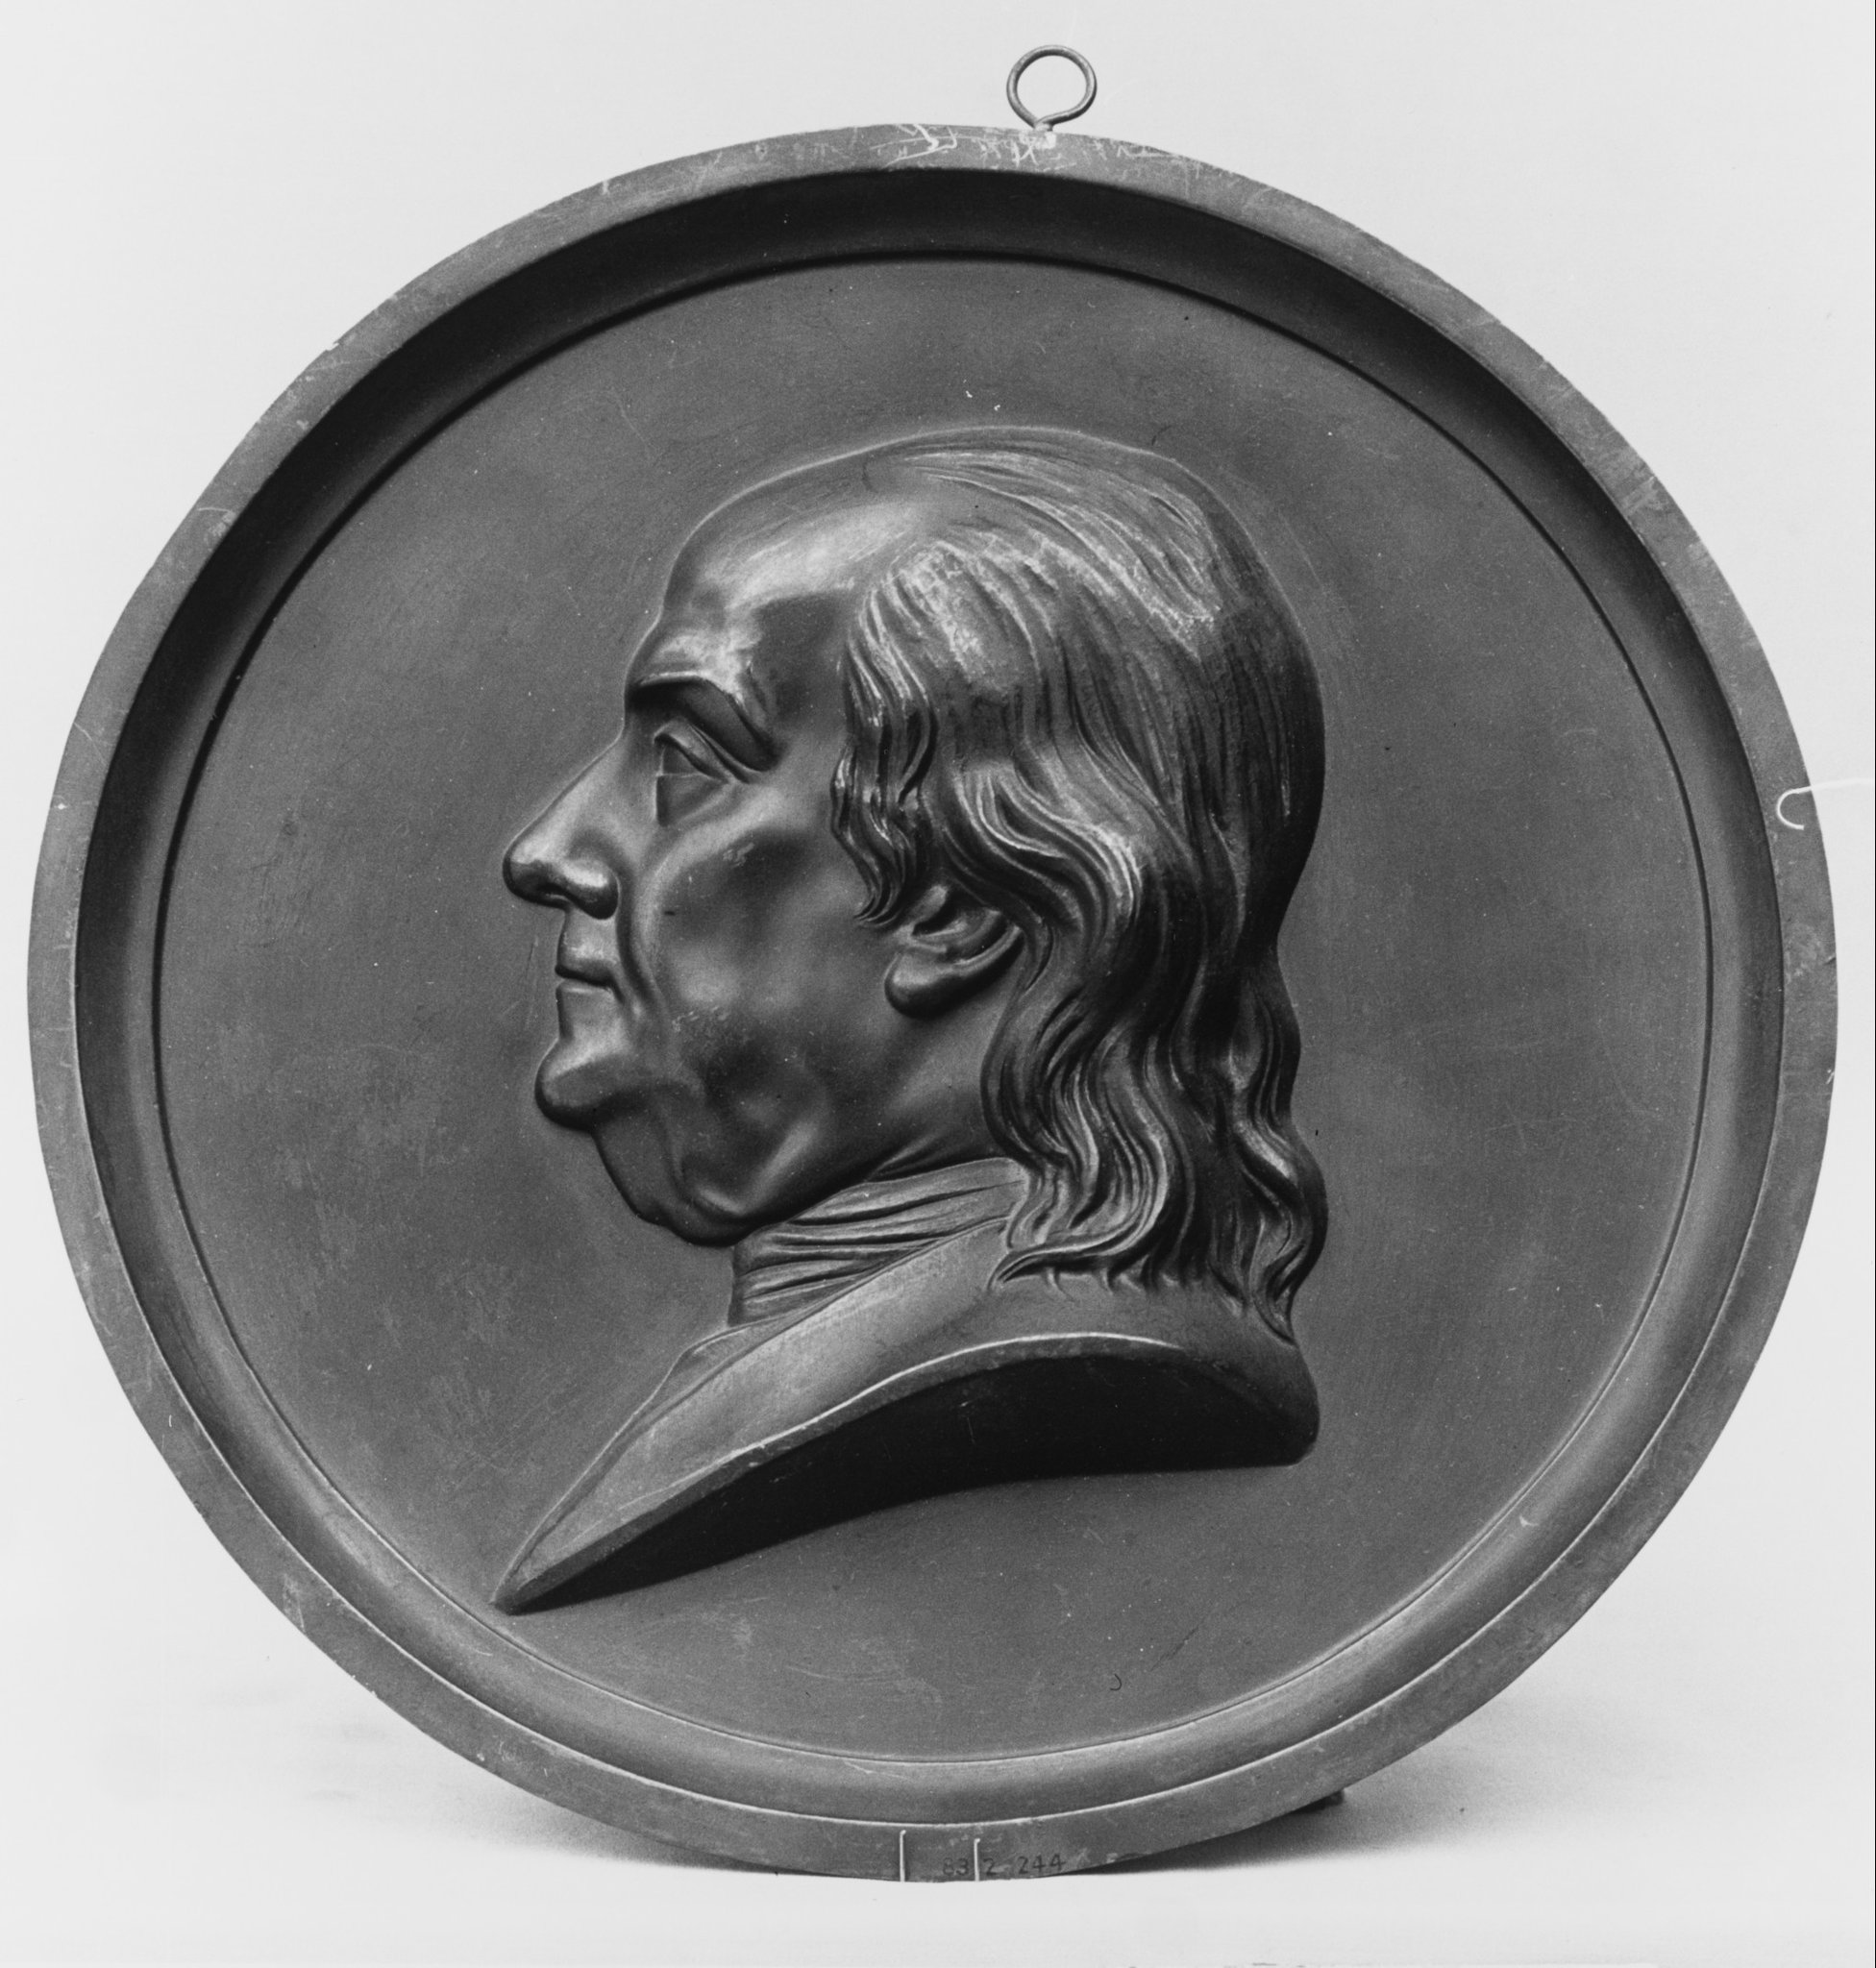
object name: plaque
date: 1800-1883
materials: copper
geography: france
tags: men,profiles